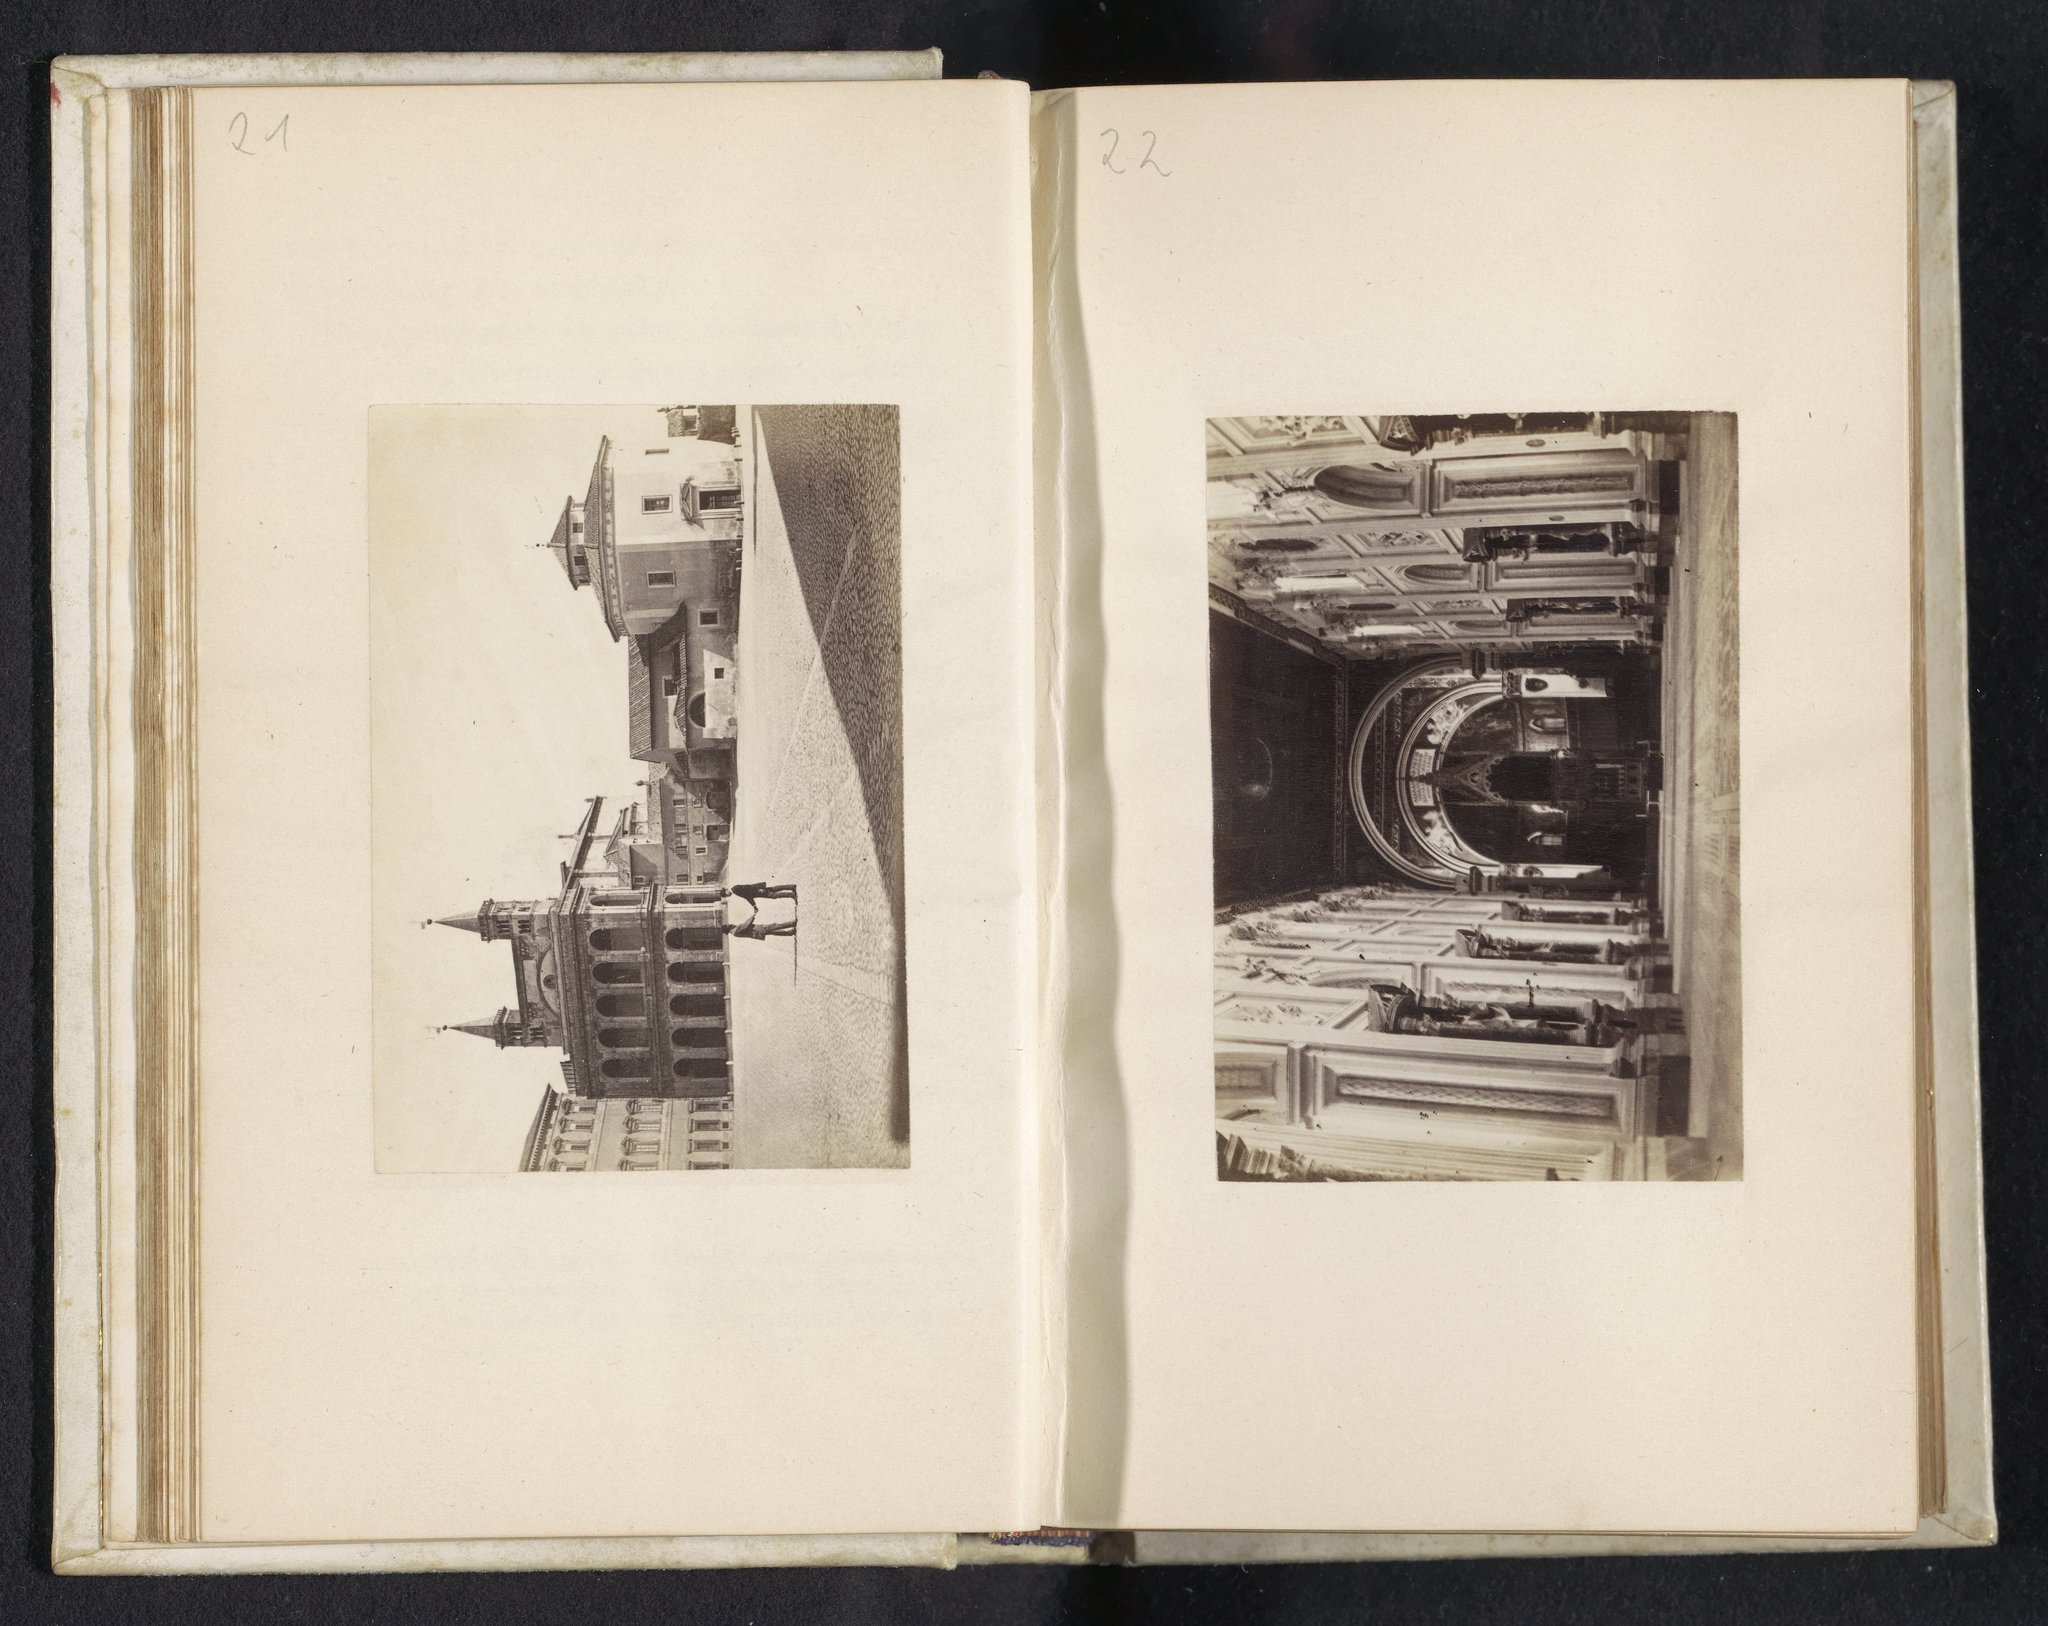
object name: page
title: Gezicht op het Piazza di San Giovanni in Laterano te Rome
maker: Anonymous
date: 1850-1860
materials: photographic support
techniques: albumen print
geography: piazza di san giovanni in laterano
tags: square, place, circus, etc., church (exterior)